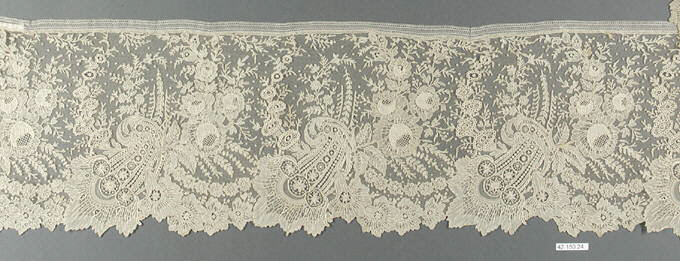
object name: border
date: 1801-1900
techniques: lace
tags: flowers